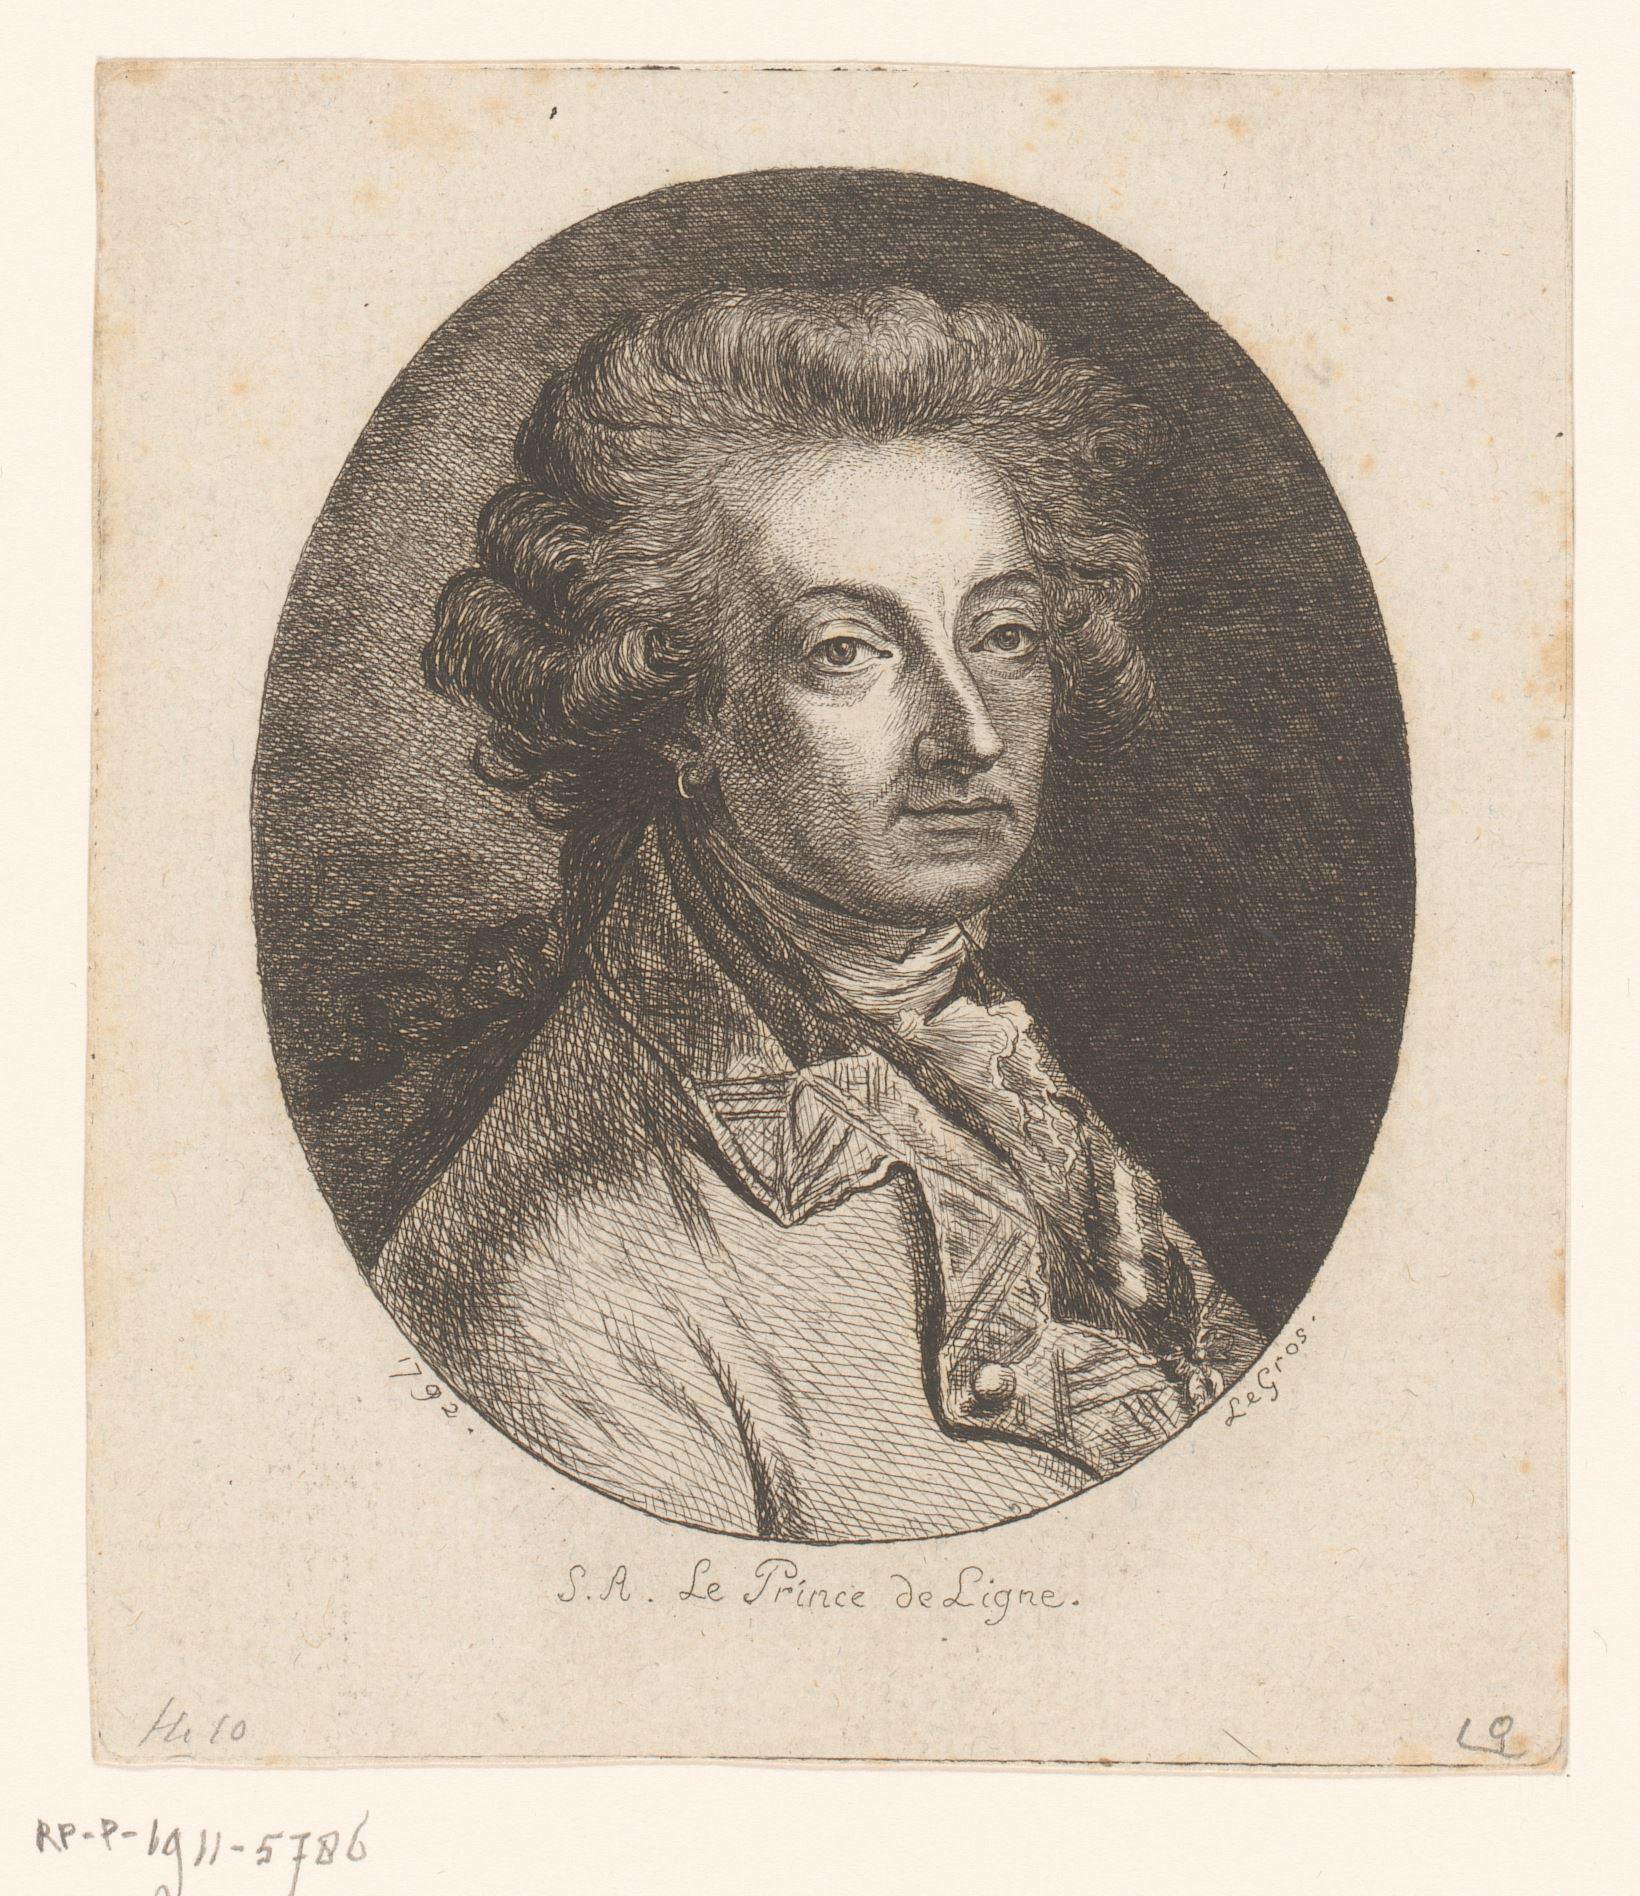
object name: print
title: S.A. Le Prince de Ligne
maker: sauveur legros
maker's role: print maker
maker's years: 1754-1834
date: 1792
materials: paper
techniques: engraving, etching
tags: prince, historical persons, portrait of a writer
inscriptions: collector's mark: Lugt 2228